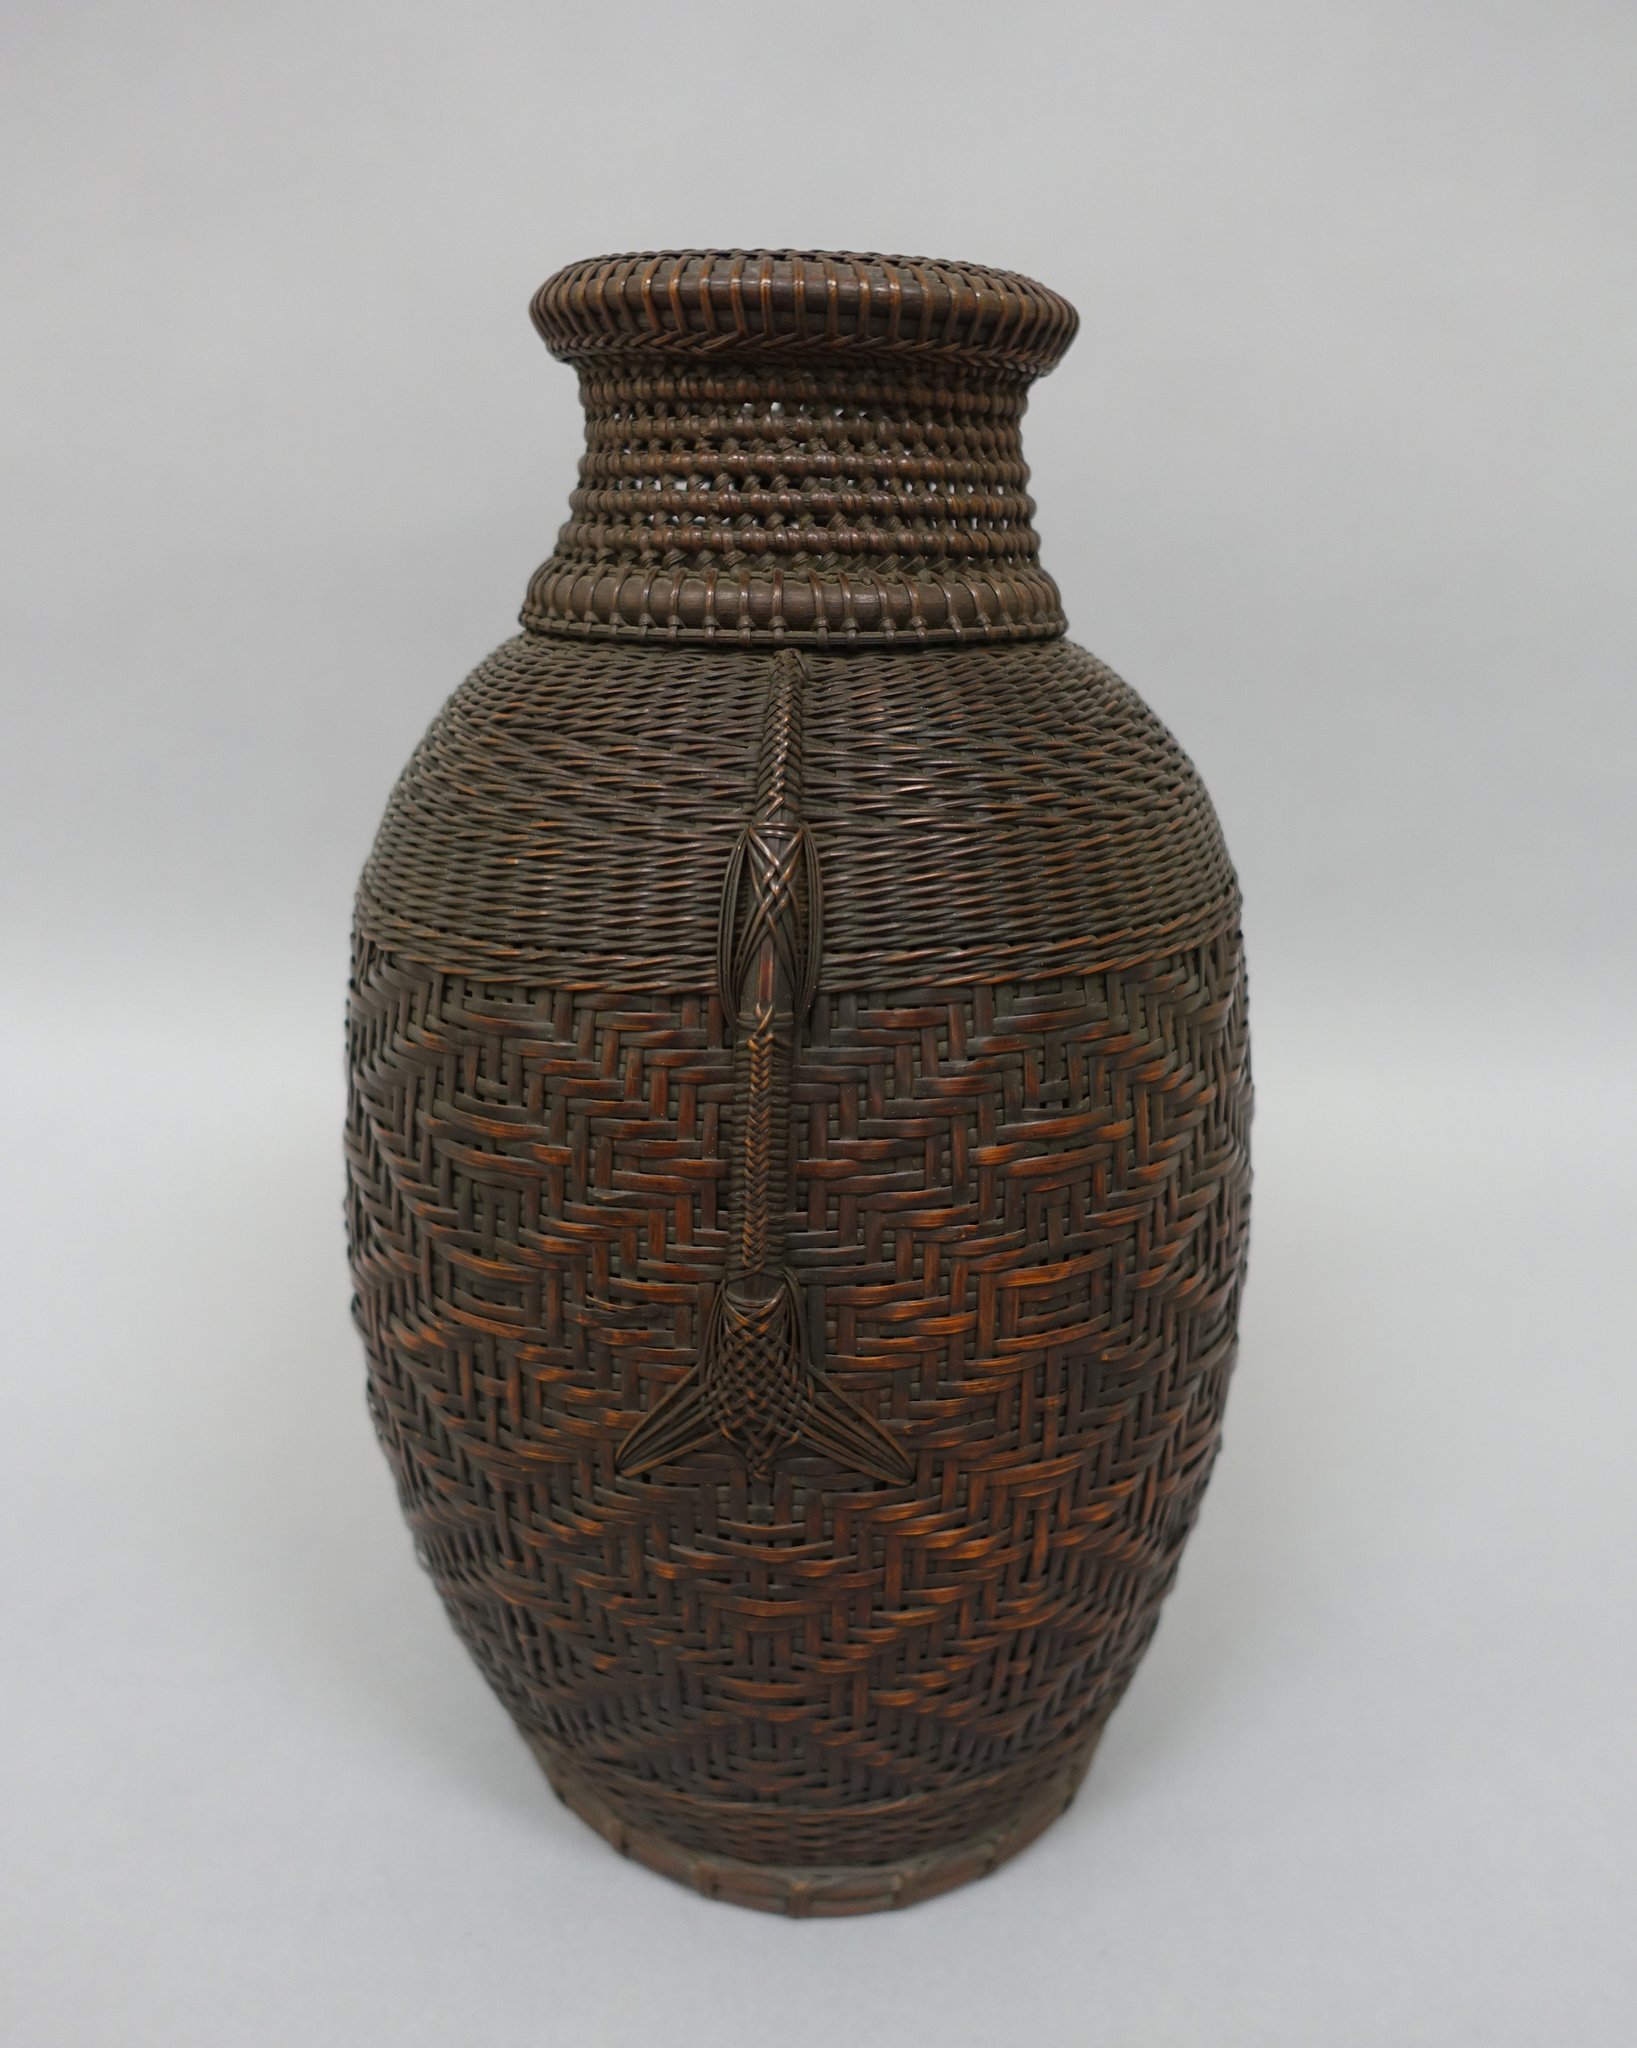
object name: basket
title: Chinese-Style Flower Basket (Karamono hanakago)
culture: japanese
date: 1834-1866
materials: bamboo, rattan